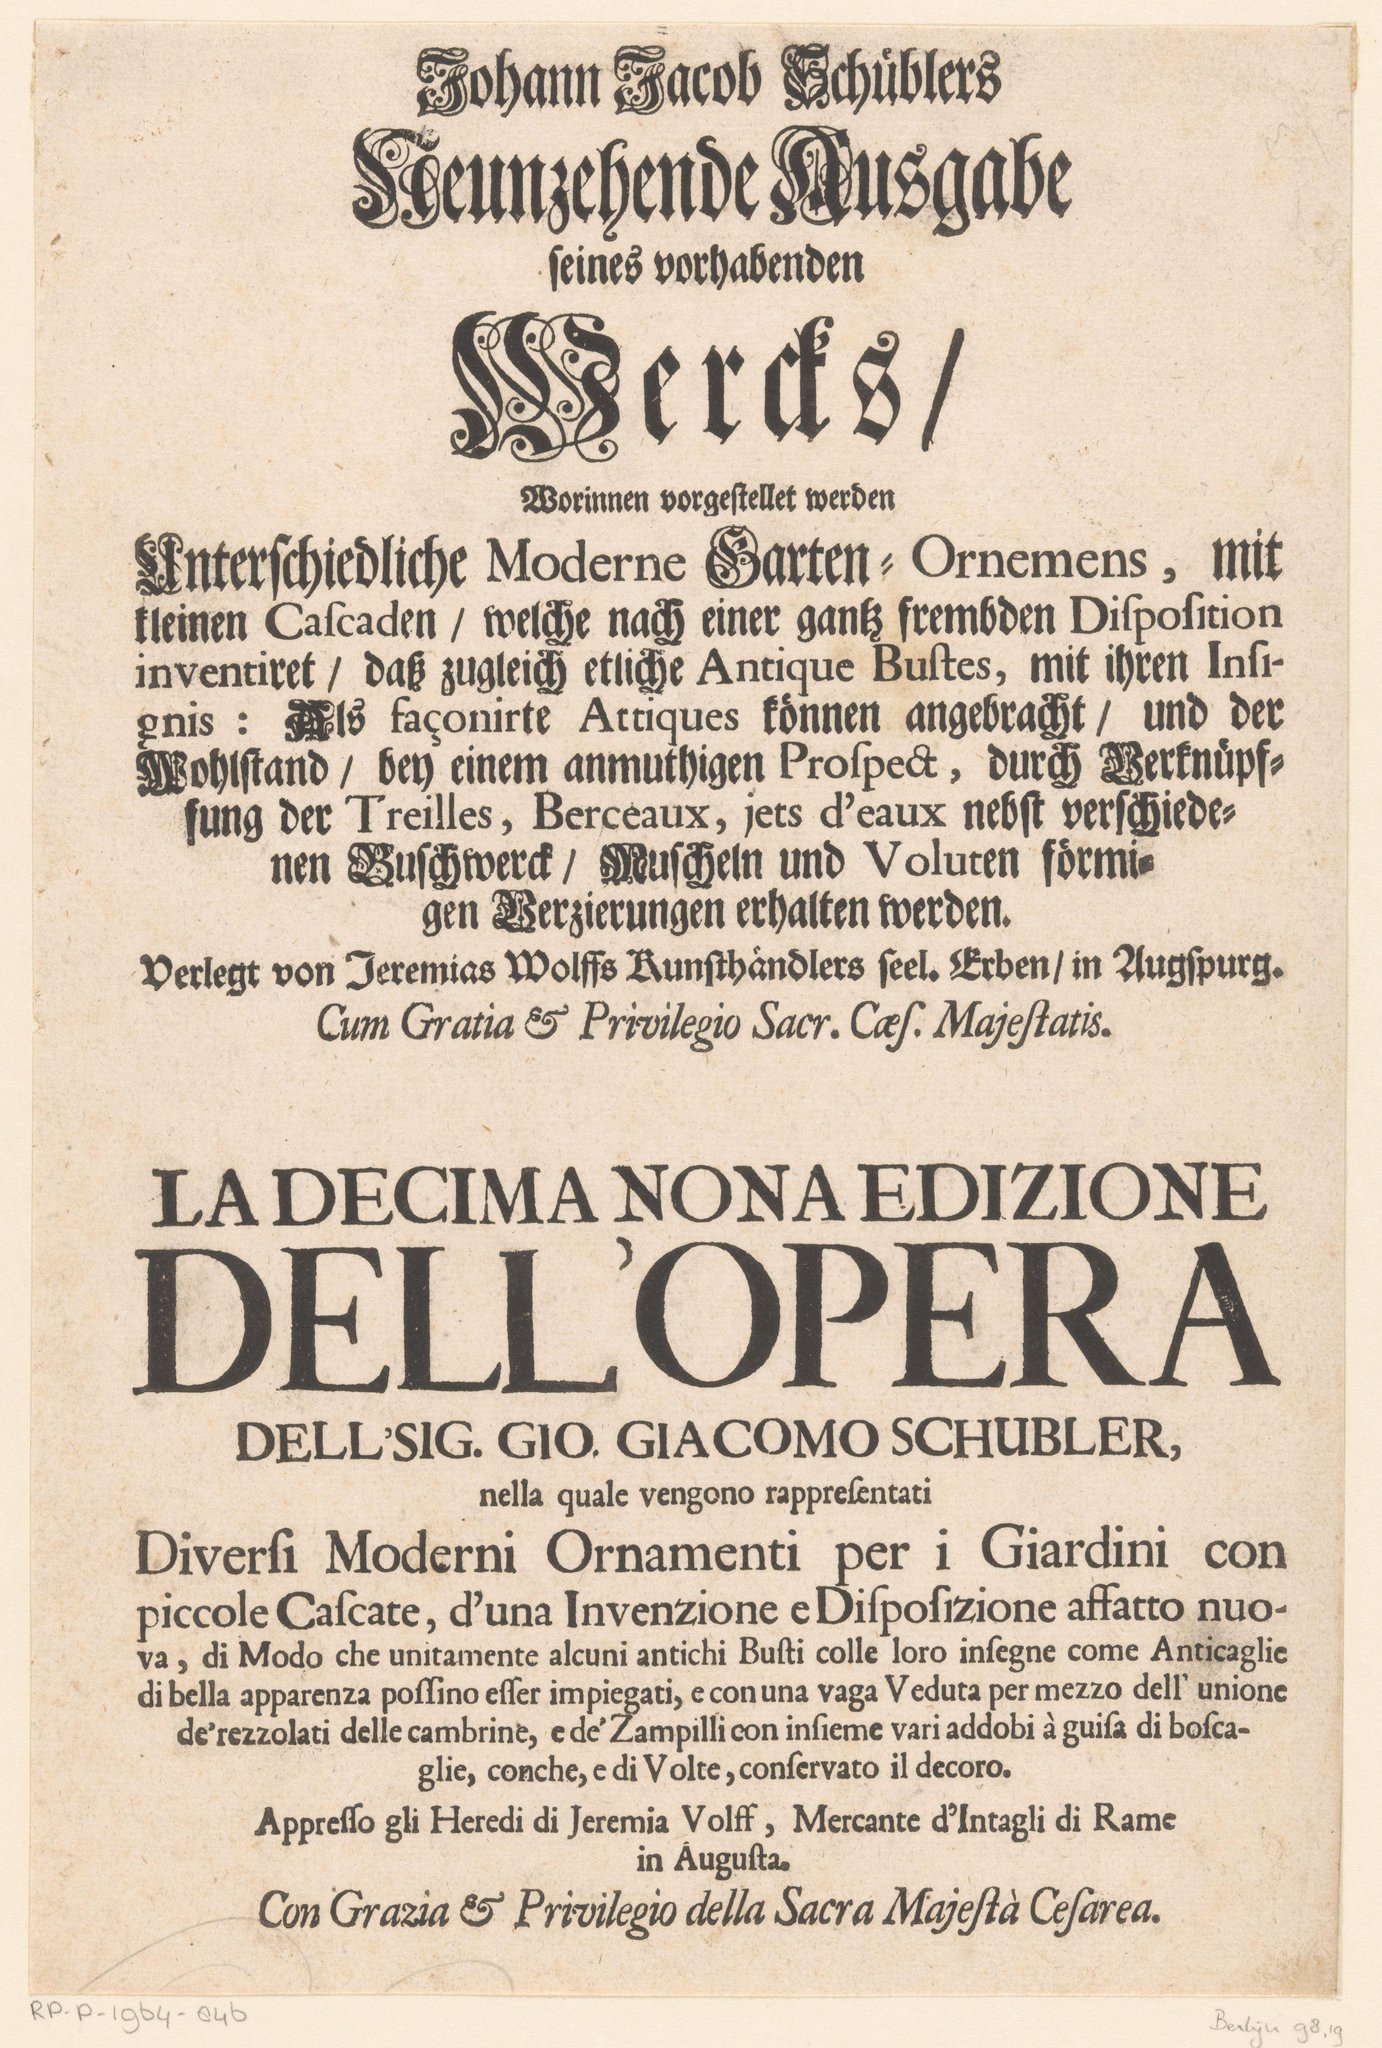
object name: ornament print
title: Johann Jacob Schüblers Neunzehende Ausgabe seines vorhabenden Wercks, Worinnen vorgestellet werden Unterschiedliche Moderne Garten-Ornemens (...)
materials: paper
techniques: letterpress printing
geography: augsburg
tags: title-page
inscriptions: collector's mark: Lugt 2228, collector's mark: Lugt 2760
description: Titel en beschrijving van de serie in Duits en Italiaans.